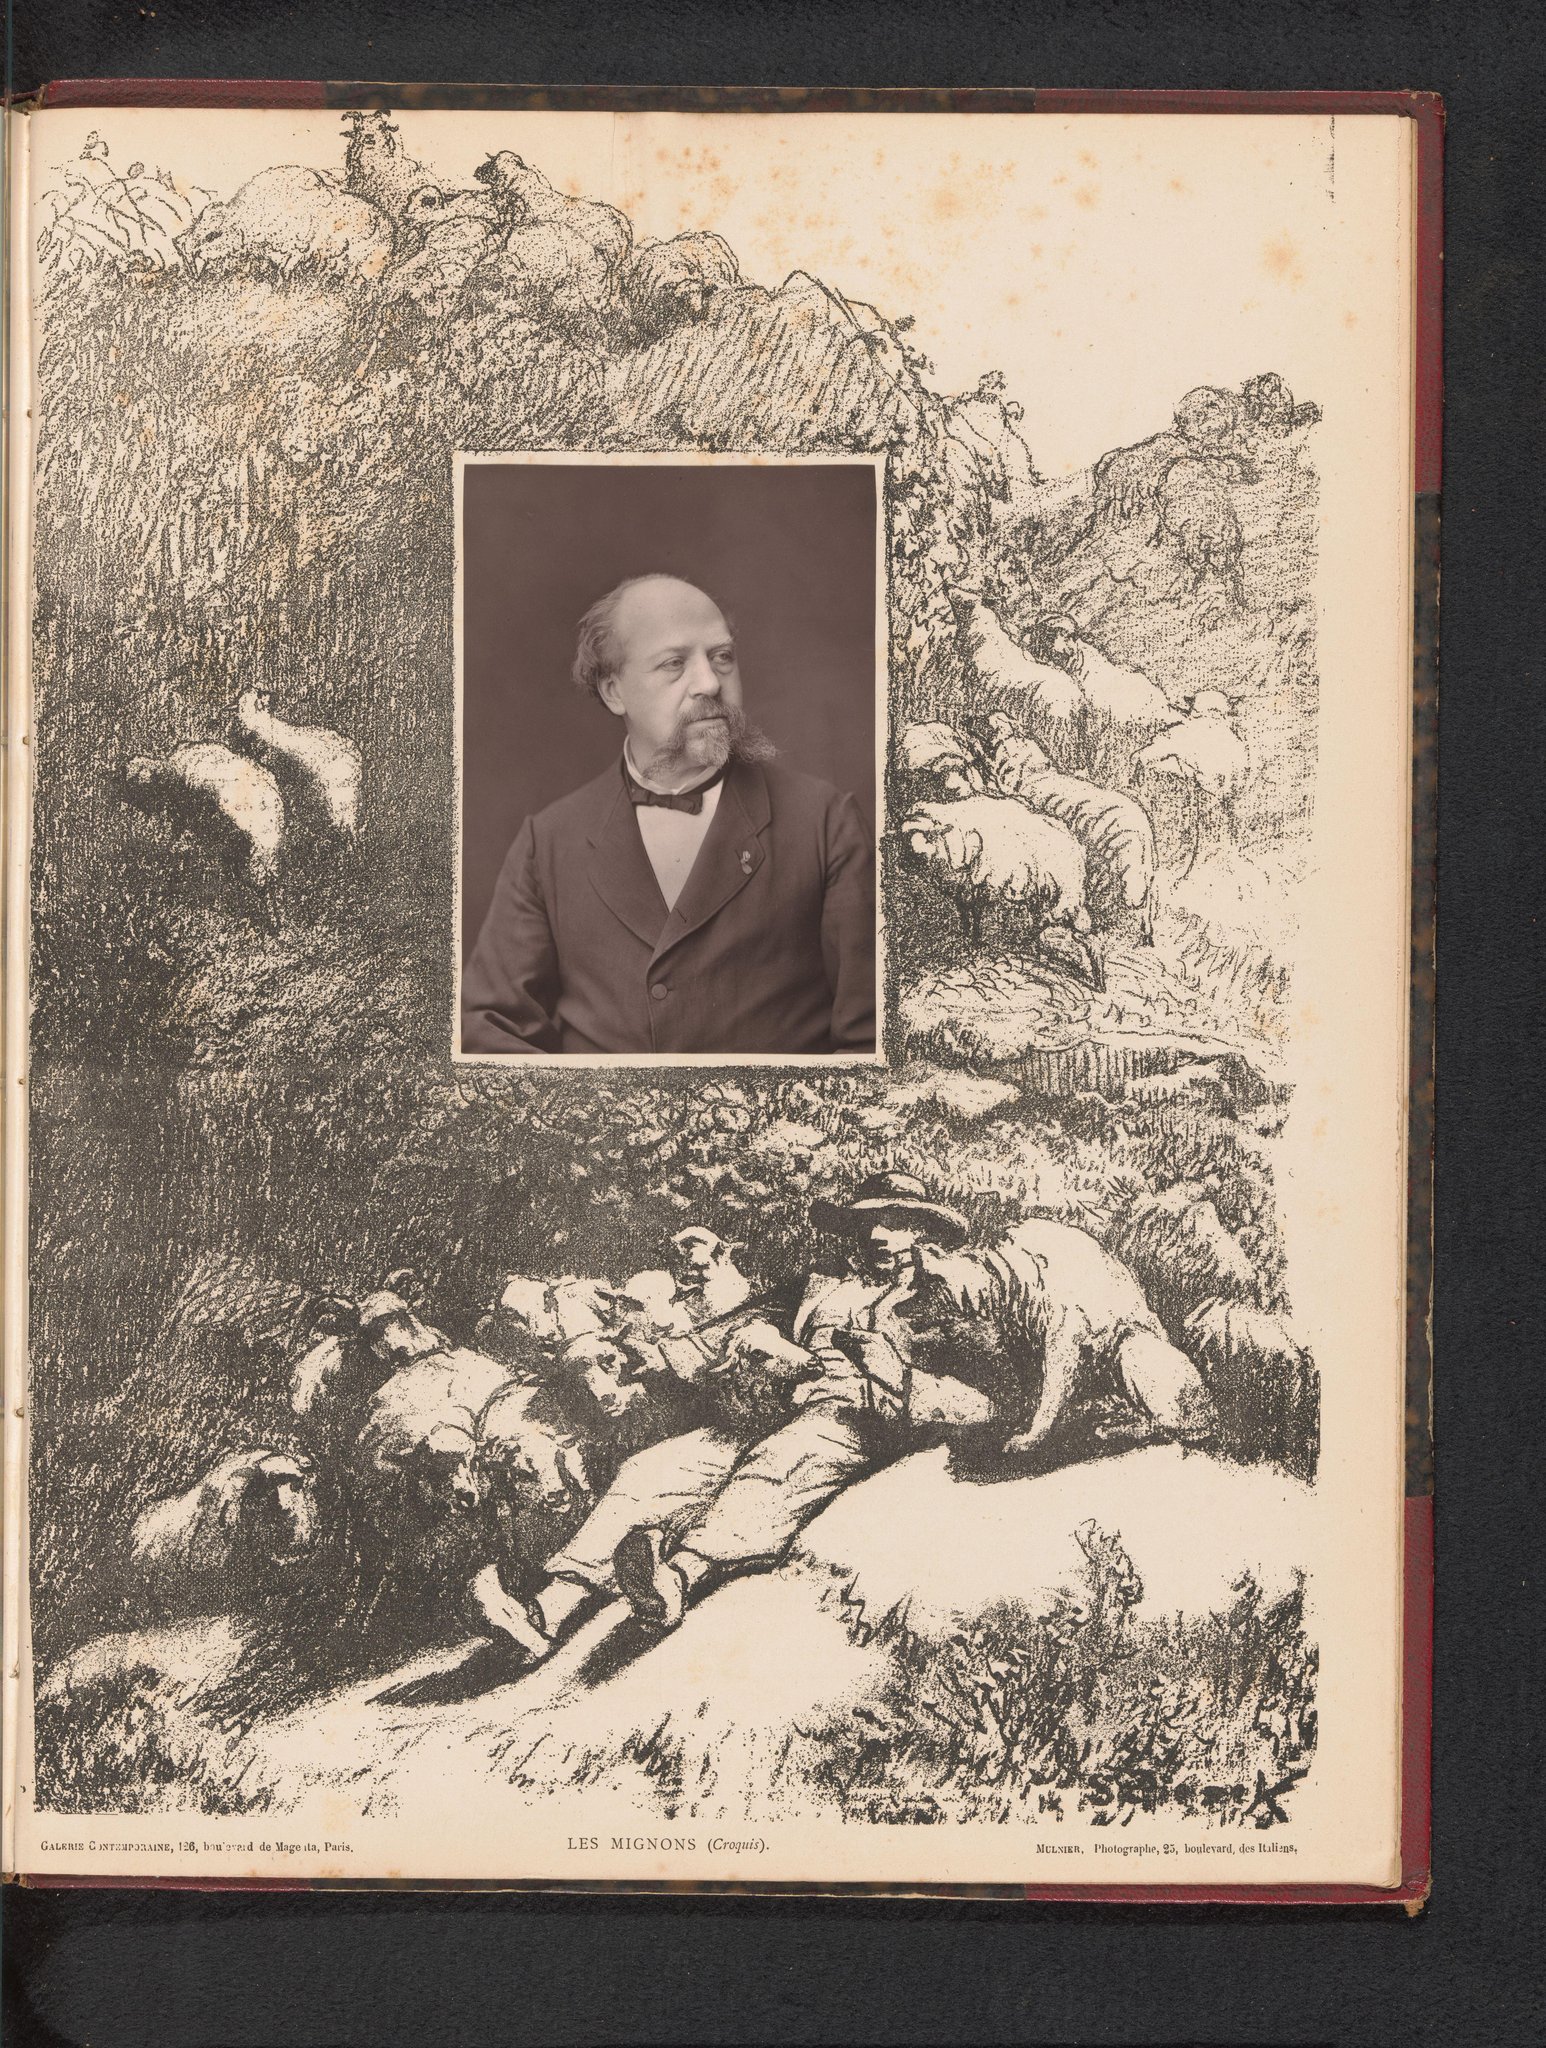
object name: photomechanical print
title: Portret van August Friedrich Albrecht Schenck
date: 1871-1876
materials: paper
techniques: woodburytype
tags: painter, august friedrich albrecht schenck, adult man, historical persons